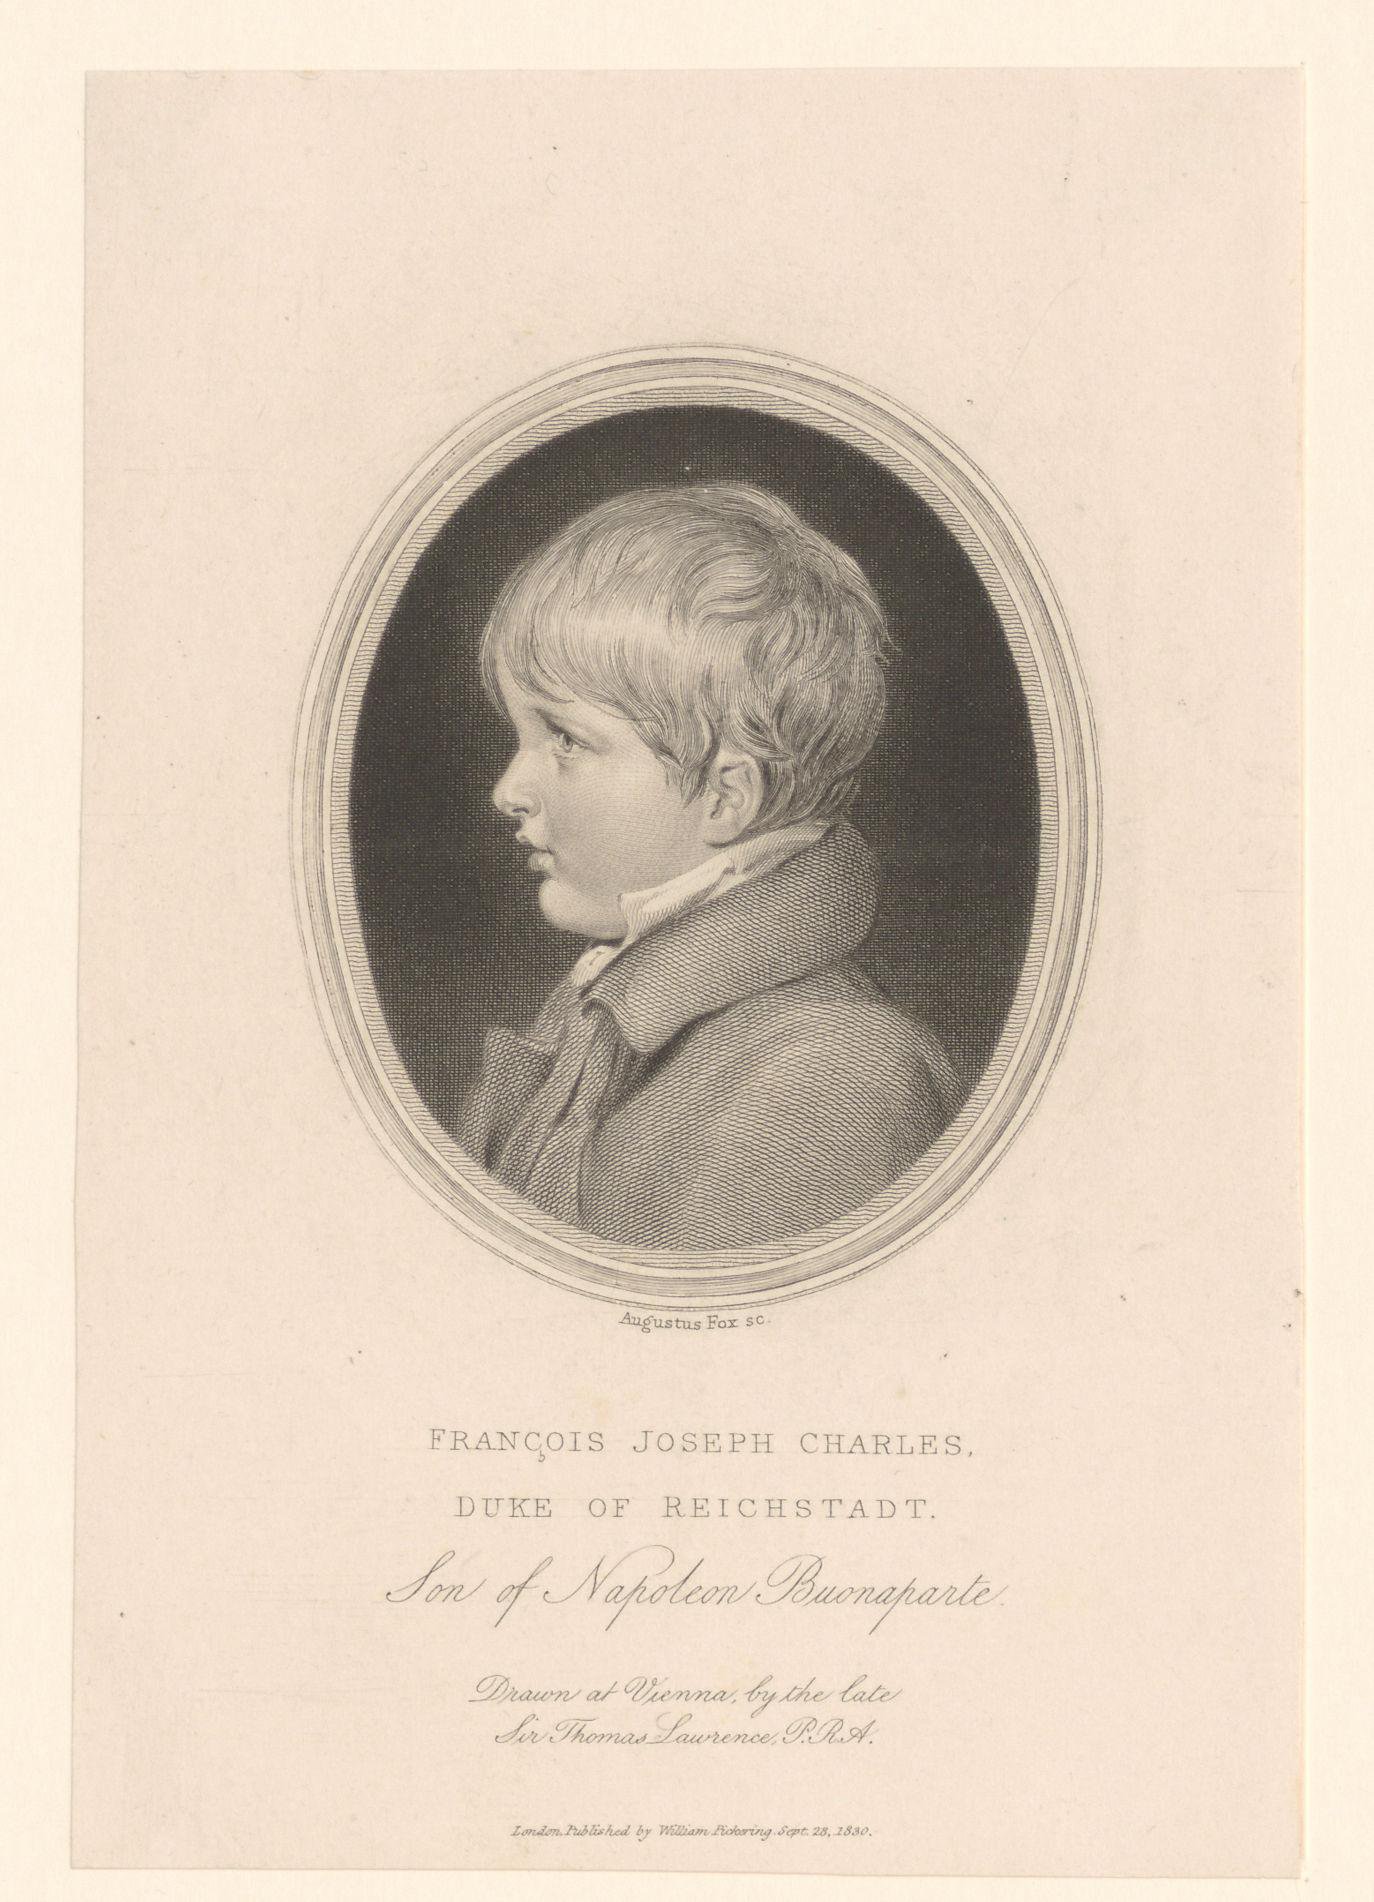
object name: print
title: François Joseph Charles, duke of Reichstadt Son of Napoleon Bonaparte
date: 1830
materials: paper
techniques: etching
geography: london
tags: paris, vienna, historical persons, ruler, sovereign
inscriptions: collector's mark: Lugt 2228